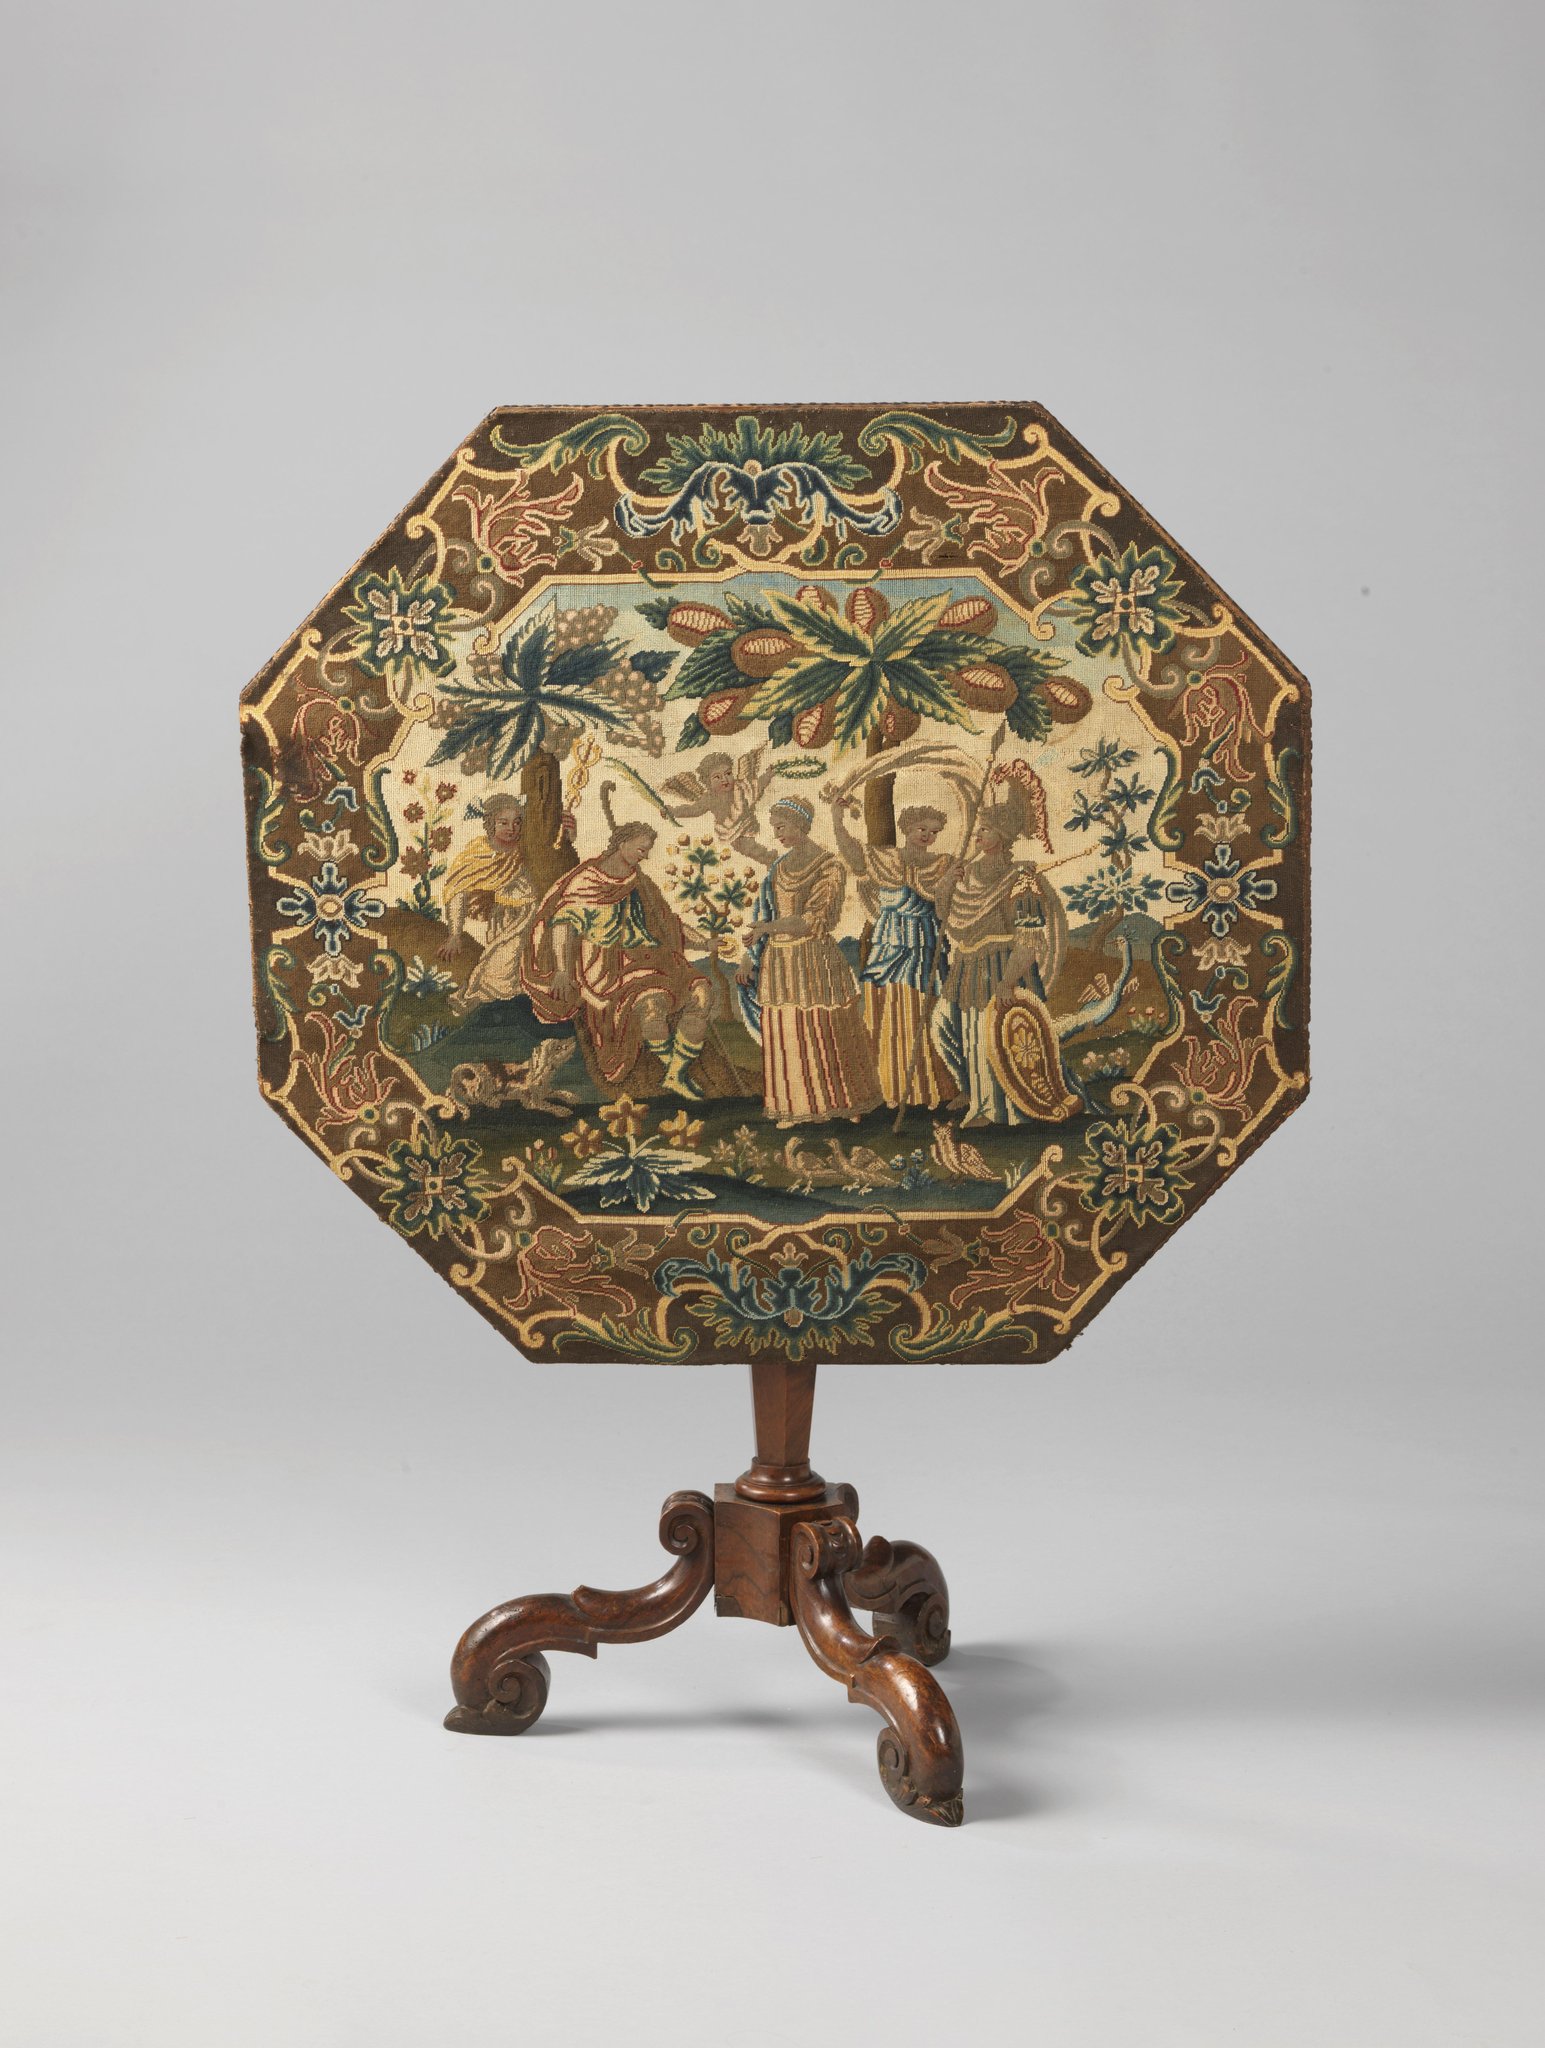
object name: folding table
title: Speeltafel met achthoekig blad, bekleed met borduurwerk in gros- en petit point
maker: Anonymous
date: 1700-1725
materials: wood, silk, wool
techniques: embroidered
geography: northern netherlands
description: Folding games' table, upholstered with wool and silk embroidery showing the Judgment of Paris. Netherlands, c. 1710 - 1750. On loan from the Koninklijk Oudheidkundig Genootschap.